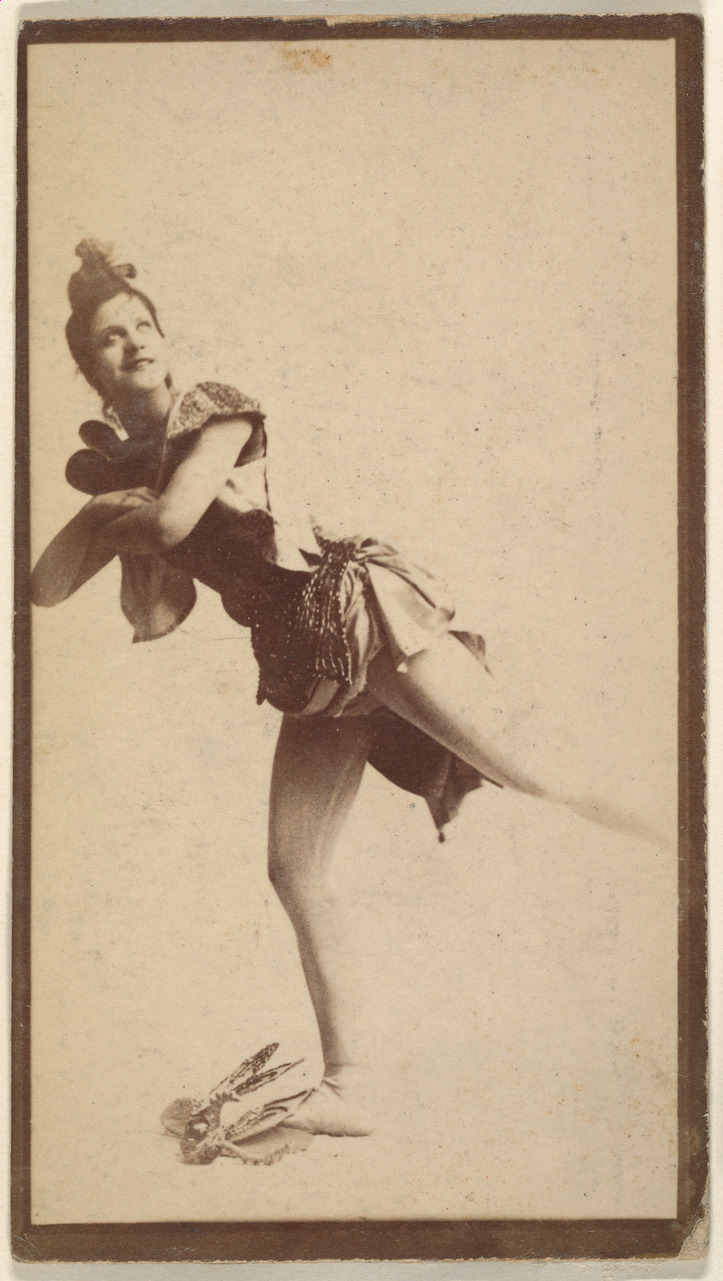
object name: photograph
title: Actress balancing on one leg, from the Actresses series (N668)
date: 1888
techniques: albumen silver print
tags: portraits,women,actresses